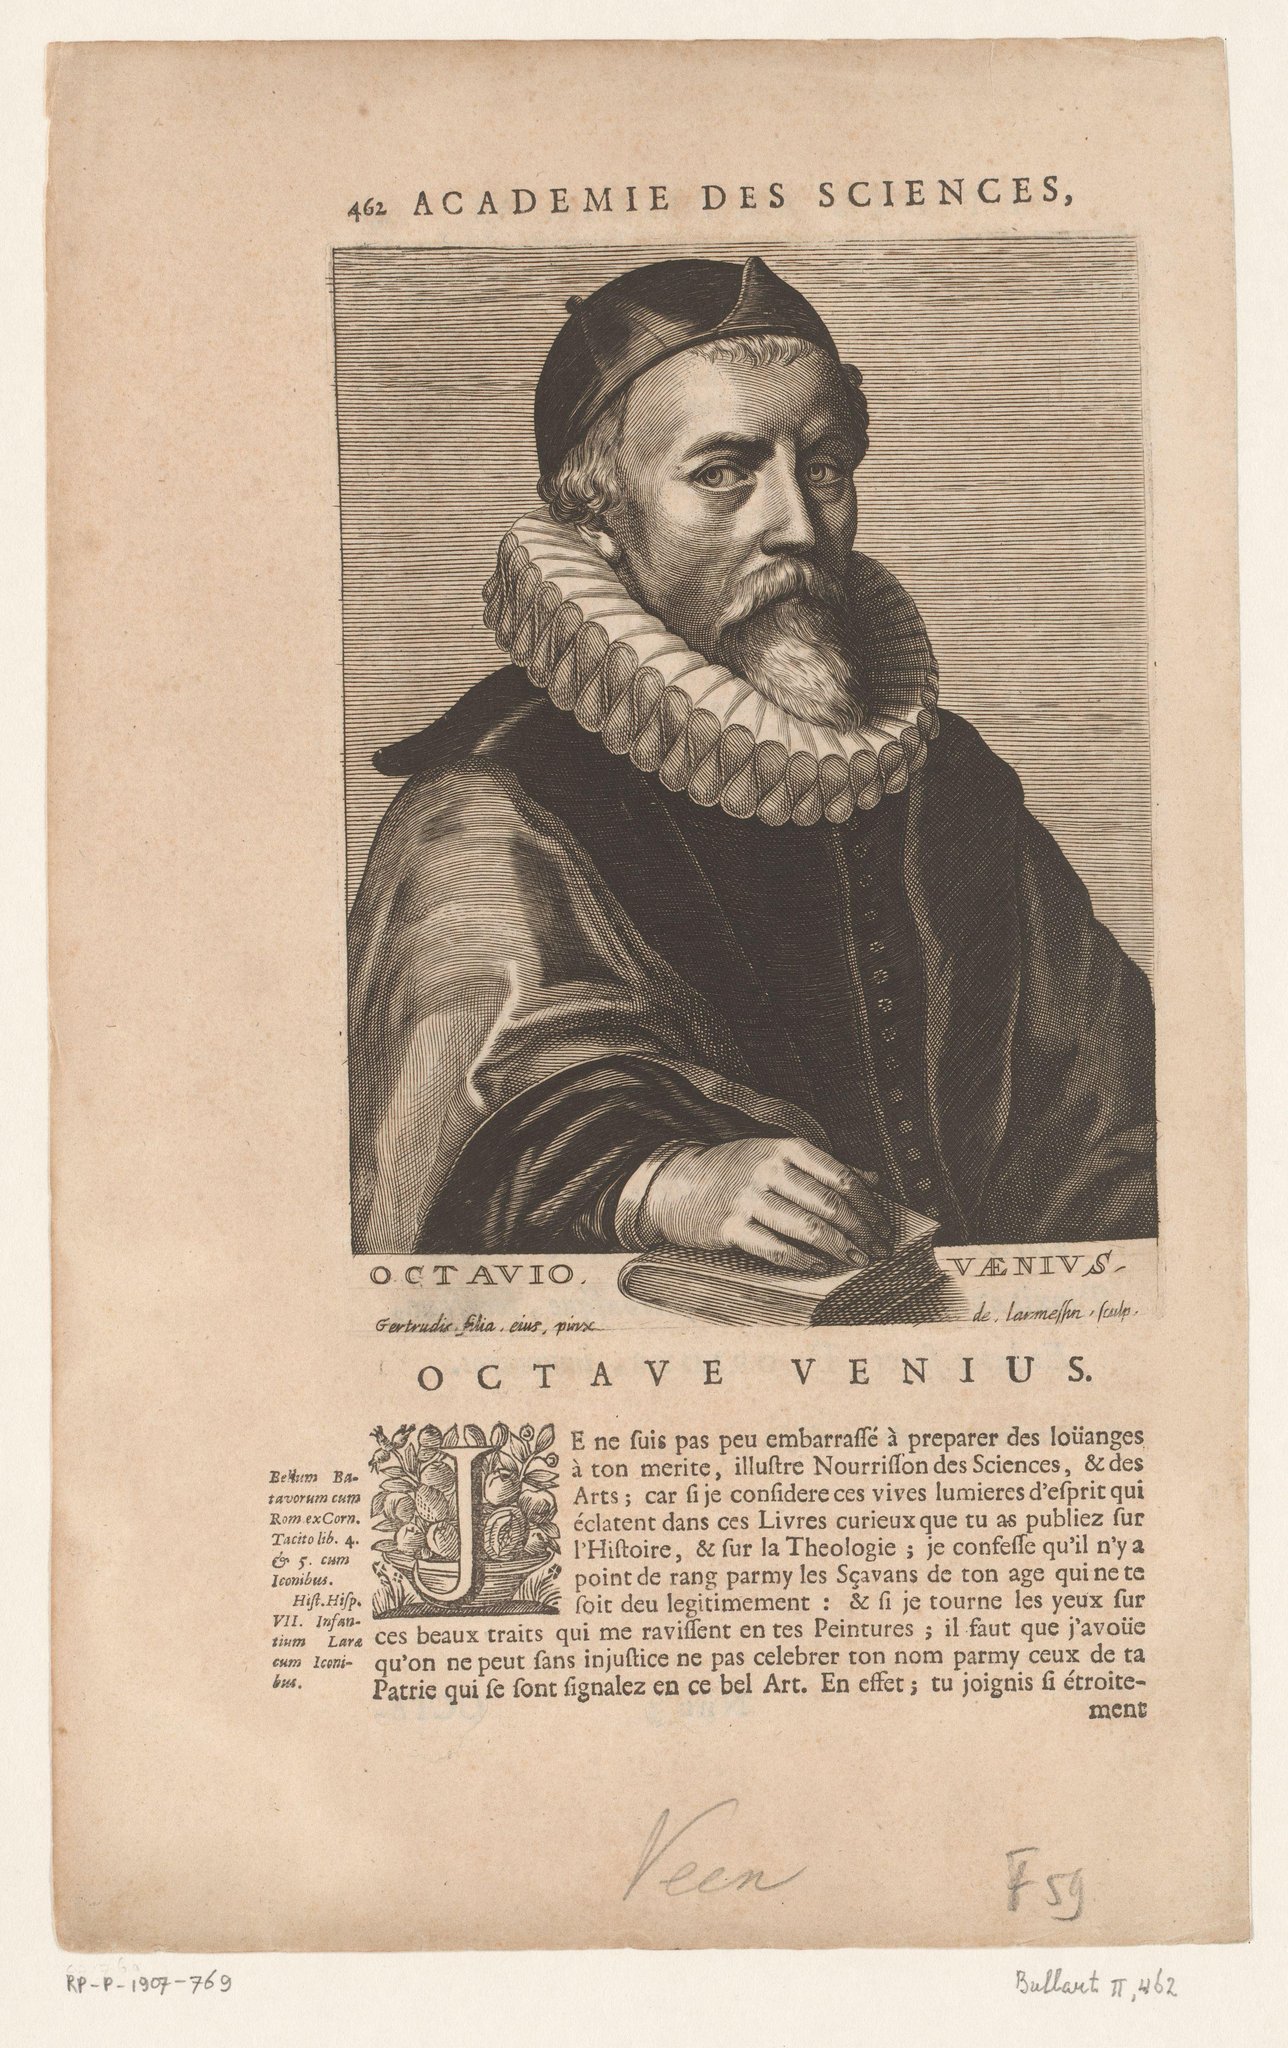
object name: print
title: Octavio Vaenius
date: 1682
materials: paper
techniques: engraving, letterpress printing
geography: brussels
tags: leiden, brussels, painter, draughtsman, otto van veen, historical persons, portrait, self-portrait of artist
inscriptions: collector's mark: Lugt 2228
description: Prent gebruikt voor: Bullart, Isaac. Académie des Sciences et Arts contenant les vies et éloges his. des hommes illustres qui ont excellé en ces professions depuis environ quatre siècles. Brussel: François Foppens, 1682. Het boek werd in 1682 eveneens in Amsterdam uitgegeven door de erfgenamen van Daniel Elzevier. Ieder portret betreft een illustratie bij de biografie van een kunstenaar of geleerde. De meeste portretten werden door Nicolas de Larmessin vervaardigd (162), 93 door De Boulonois en een derde door ongeïdentificeerde prentmakers. Dit betreft een illustratie op p. 462, deel II.